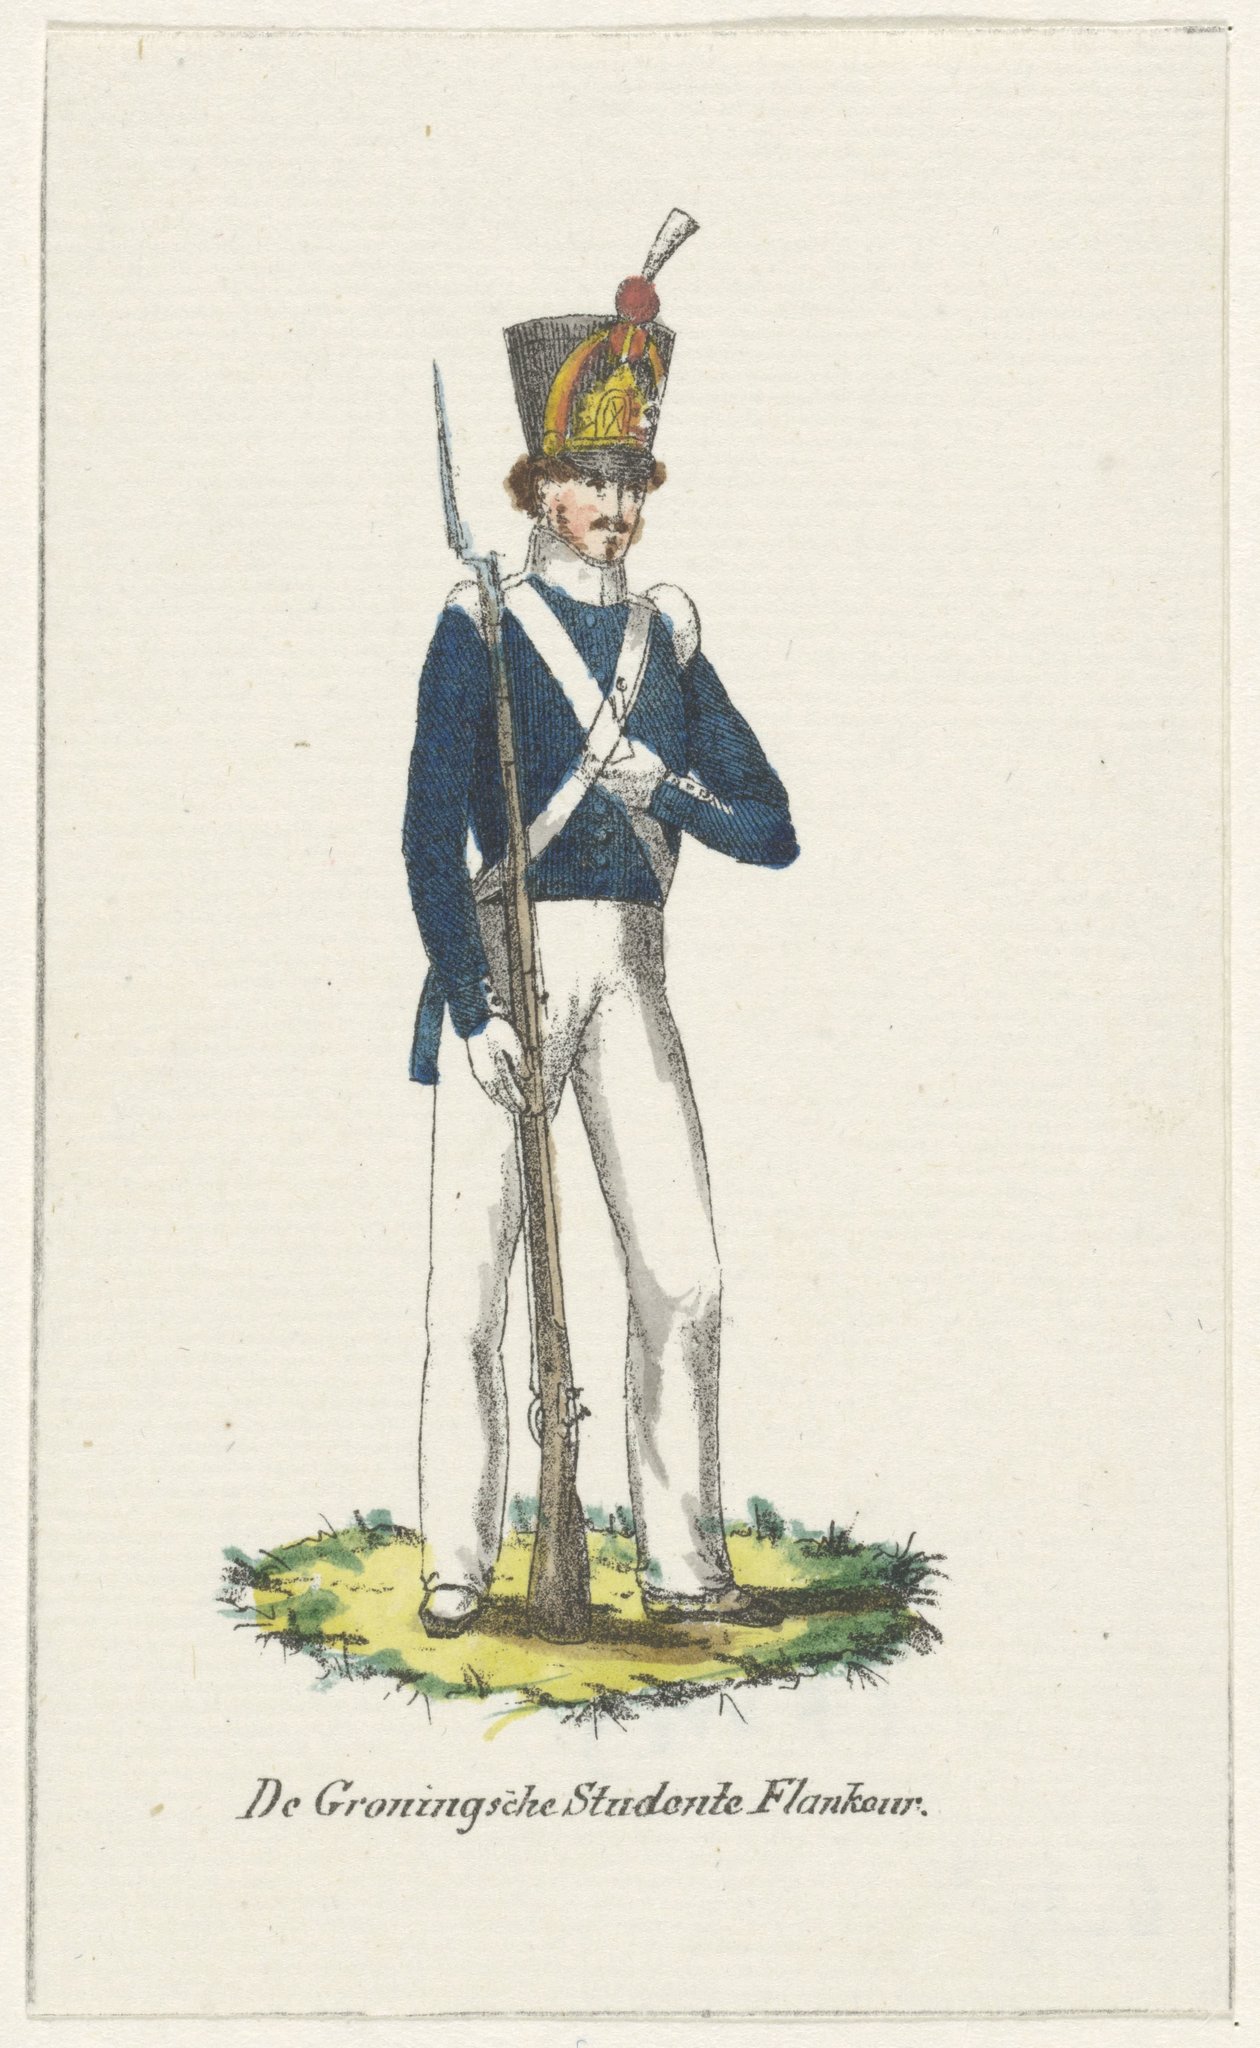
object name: print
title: De Groningsche Studente Flankeur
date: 1830-1835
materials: paper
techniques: hand coloring, lithograph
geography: amsterdam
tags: (military) uniforms, clothes, costume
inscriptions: collector's mark: Lugt 2228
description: Verkleinde kopieën naar de prenten van Houtman e.a. in FMH 6481. Muller beschrijft een onversneden compleet blad in de collectie Van Gijn waarop de namen van de prentmaker en de uitgever vermeld staan.